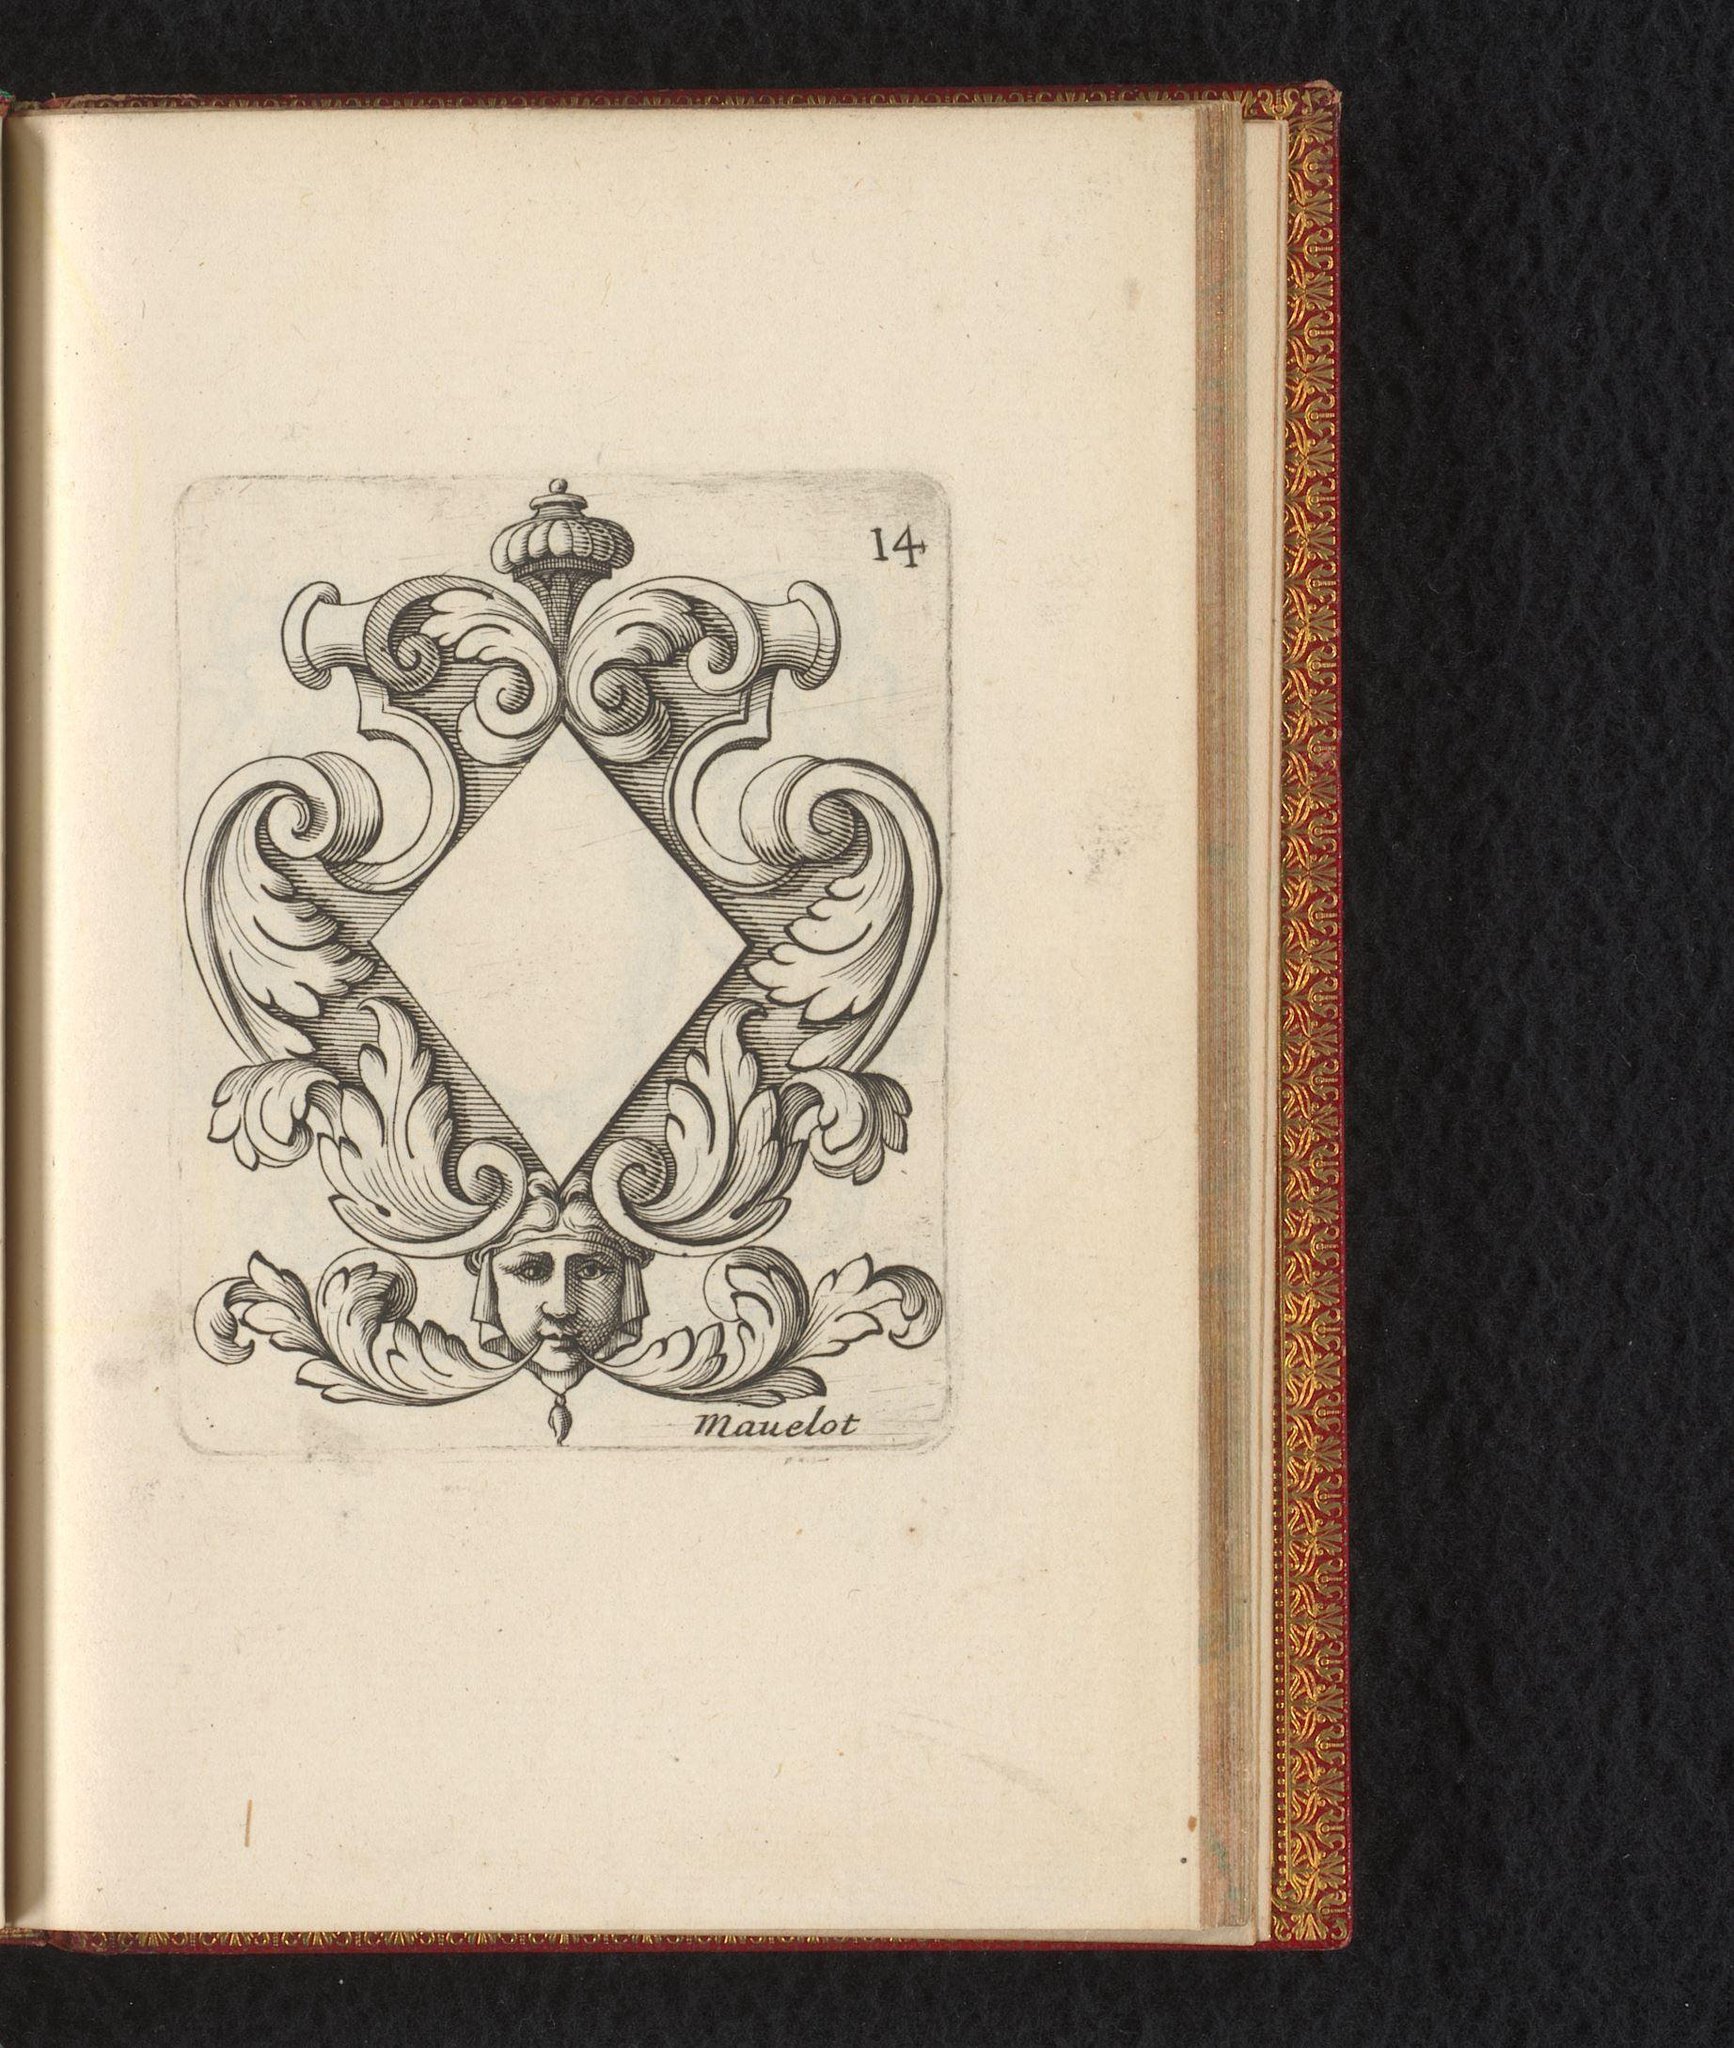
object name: album leaf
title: Cartouche met ruitvormig medaillon en mascaron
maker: charles mavelot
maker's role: draughtsman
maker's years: 1680-1742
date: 1685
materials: paper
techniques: engraving, etching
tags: acanthus ~ ornament, scrollwork, strapwork ~ ornament, ornament ~ cartouche, mask, mascaron ~ ornament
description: Rechtsboven genummerd: 14. Prent maakt deel uit van een album.